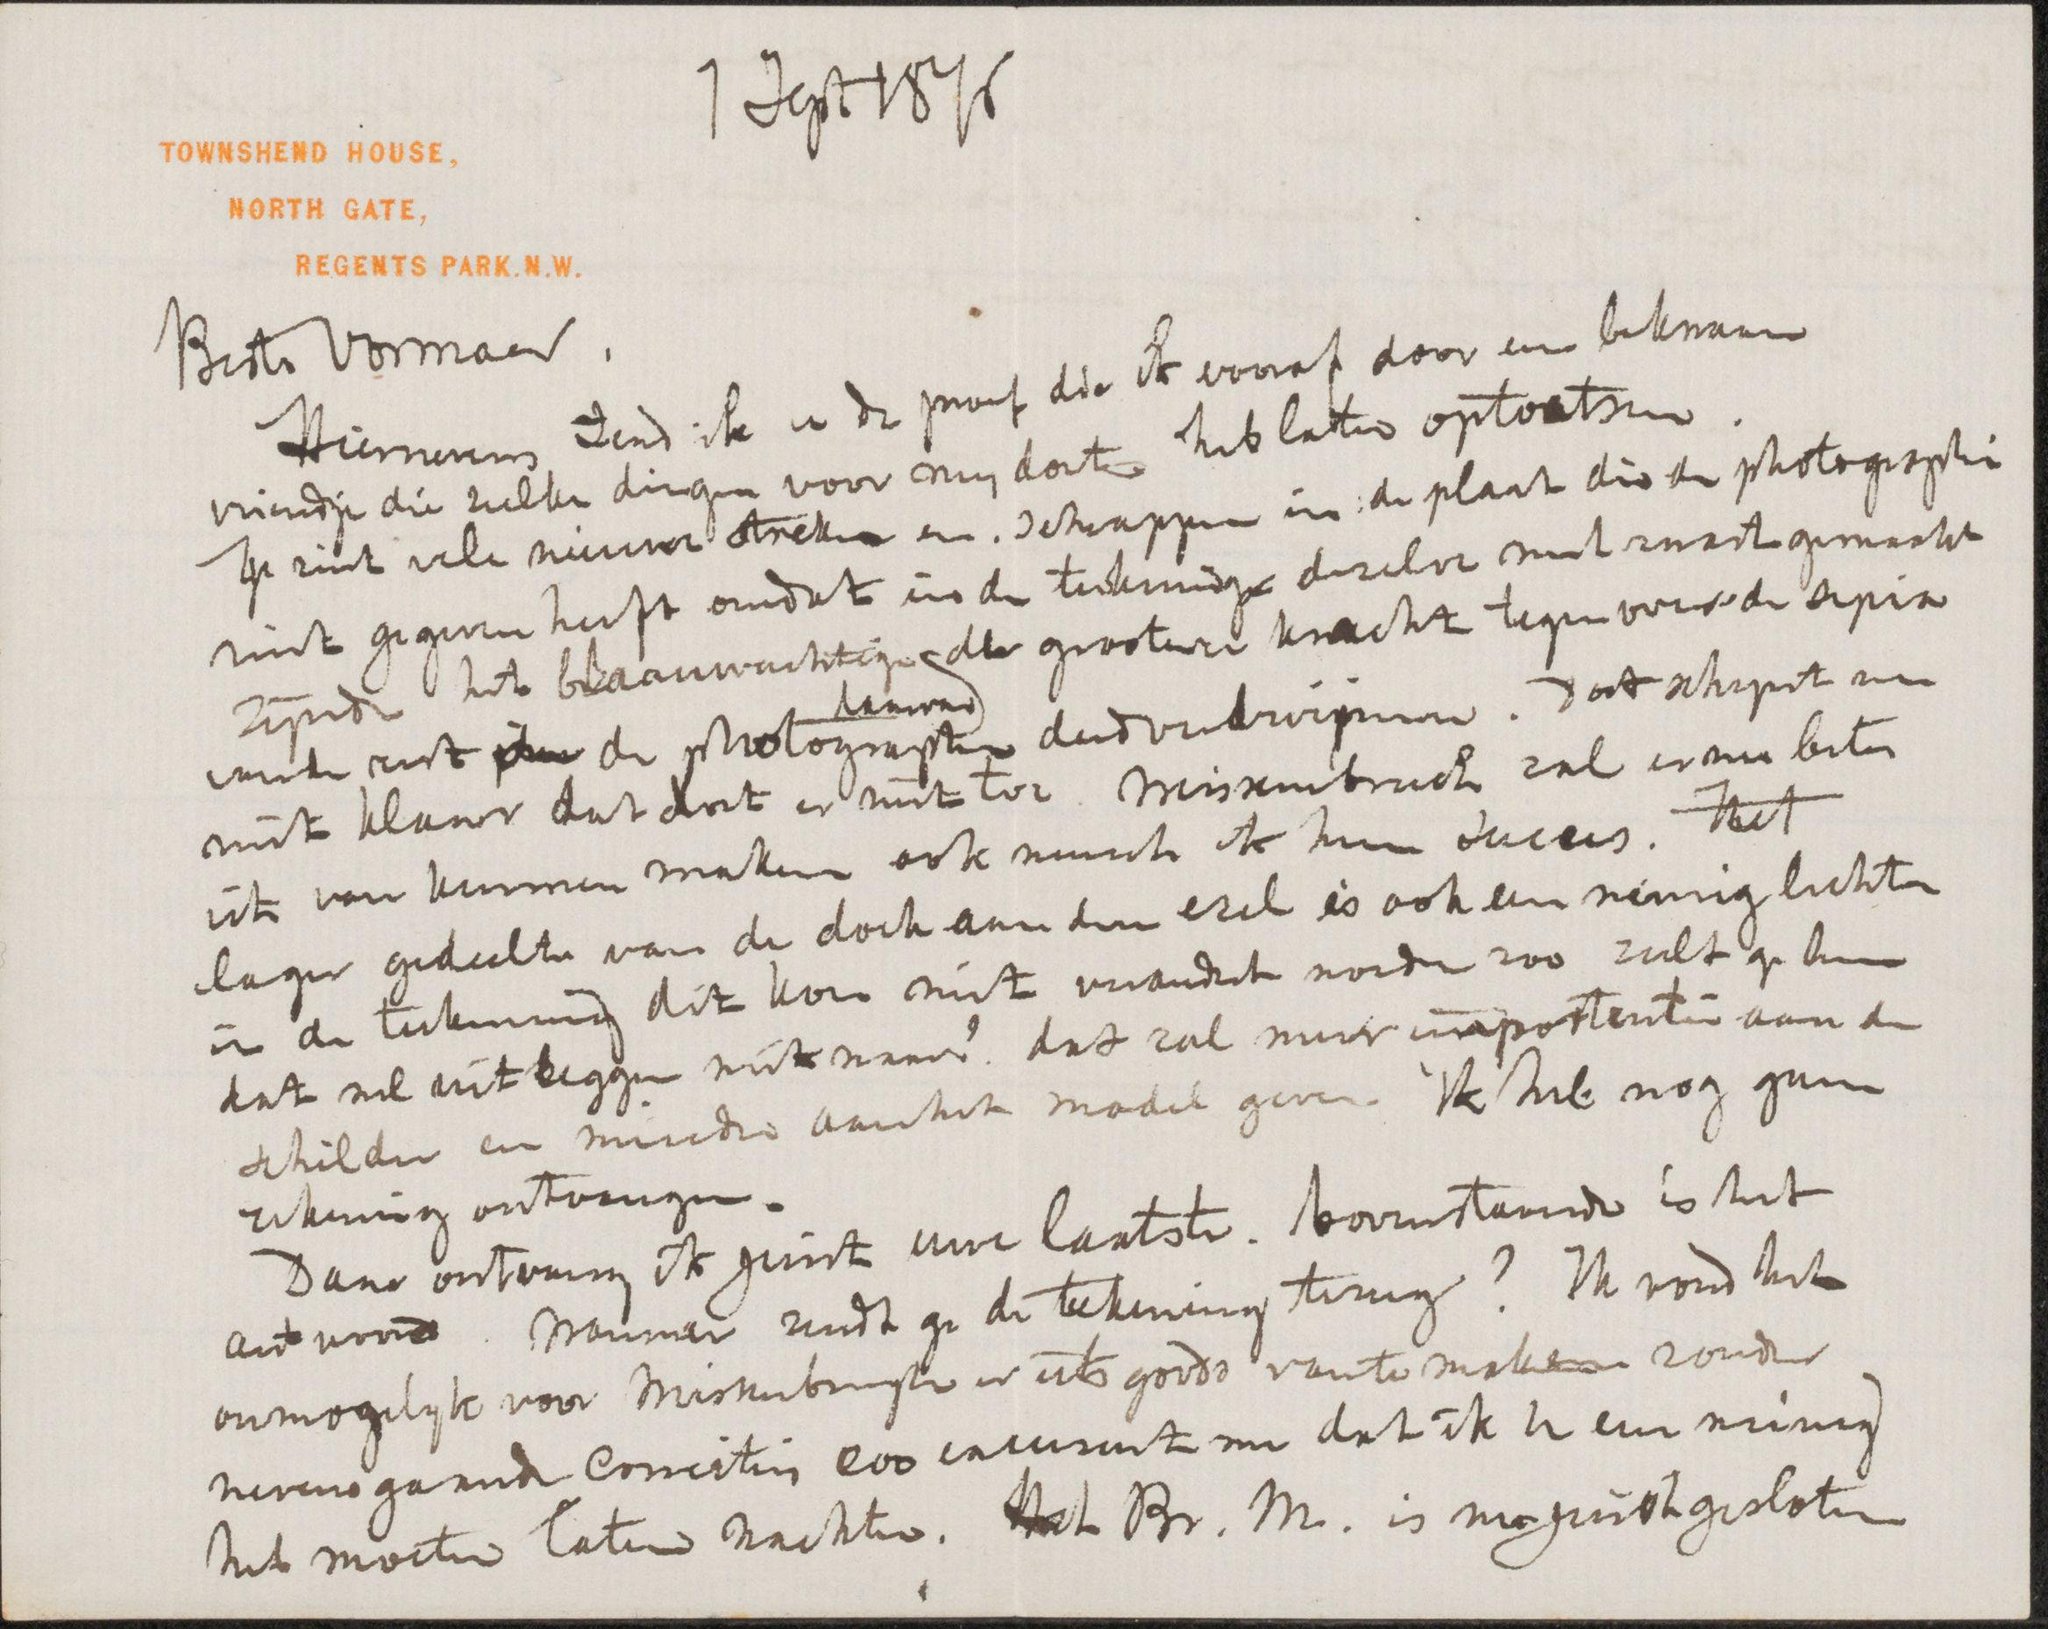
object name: letter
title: Brief aan Carel Vosmaer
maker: lourens alma tadema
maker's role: draughtsman, print maker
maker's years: 1836-1912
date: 1876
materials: ink, paper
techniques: pen, printing, writing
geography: london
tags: the hague, print maker, draughtsman, carel vosmaer, artist's model, sitter, drawing, photography, cinematography, painting (including book-illumination, miniature-painting), money